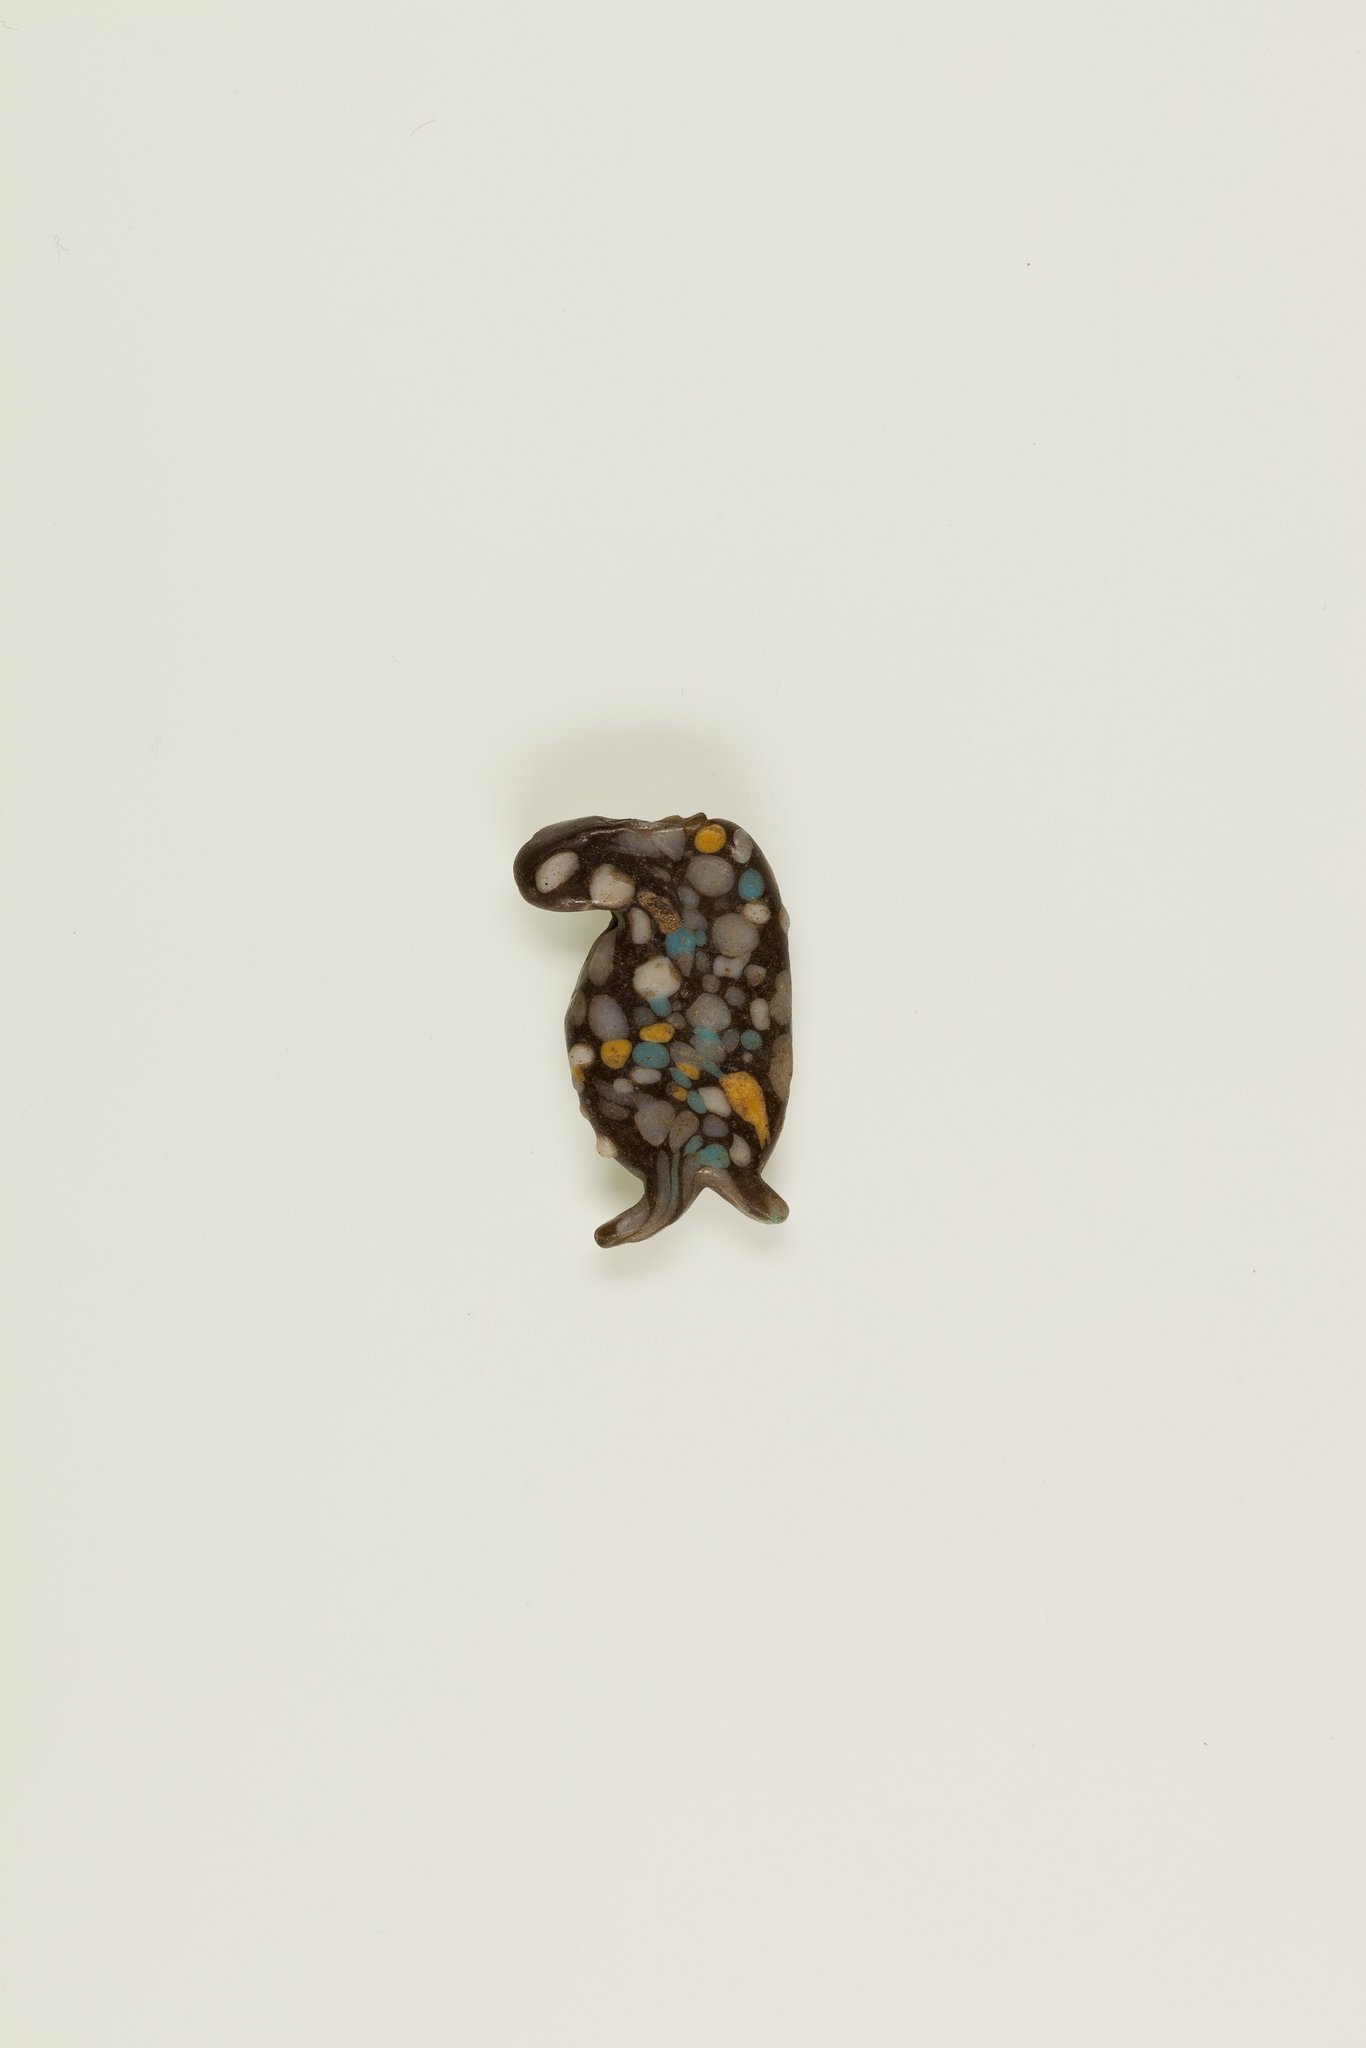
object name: amulet, taweret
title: Taweret amulet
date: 100 BCE-100 CE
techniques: mosaic glass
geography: egypt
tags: taweret